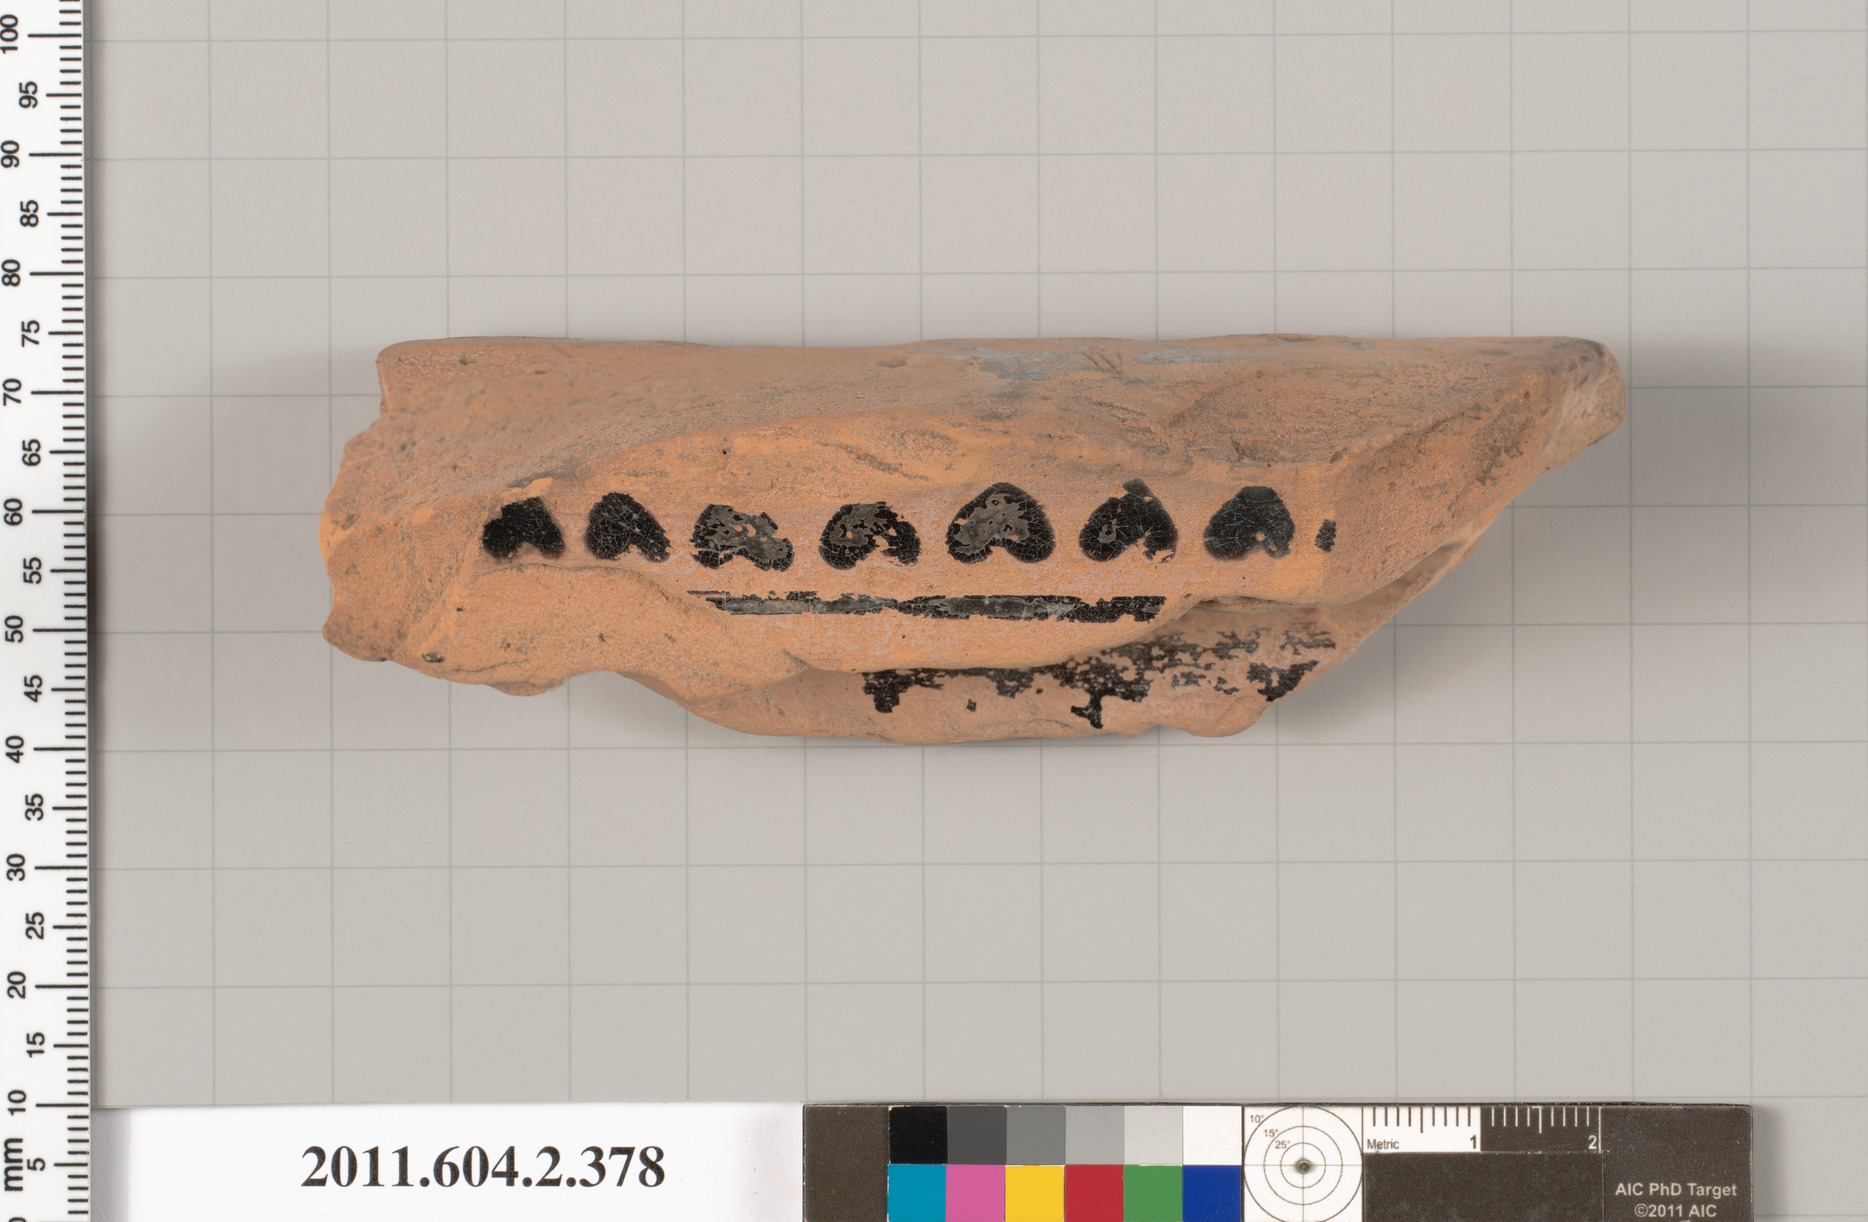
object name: column krater fragment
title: Terracotta fragment of a column-krater (bowl for mixing wine and water)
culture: greek, attic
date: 470-440 BCE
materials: terracotta